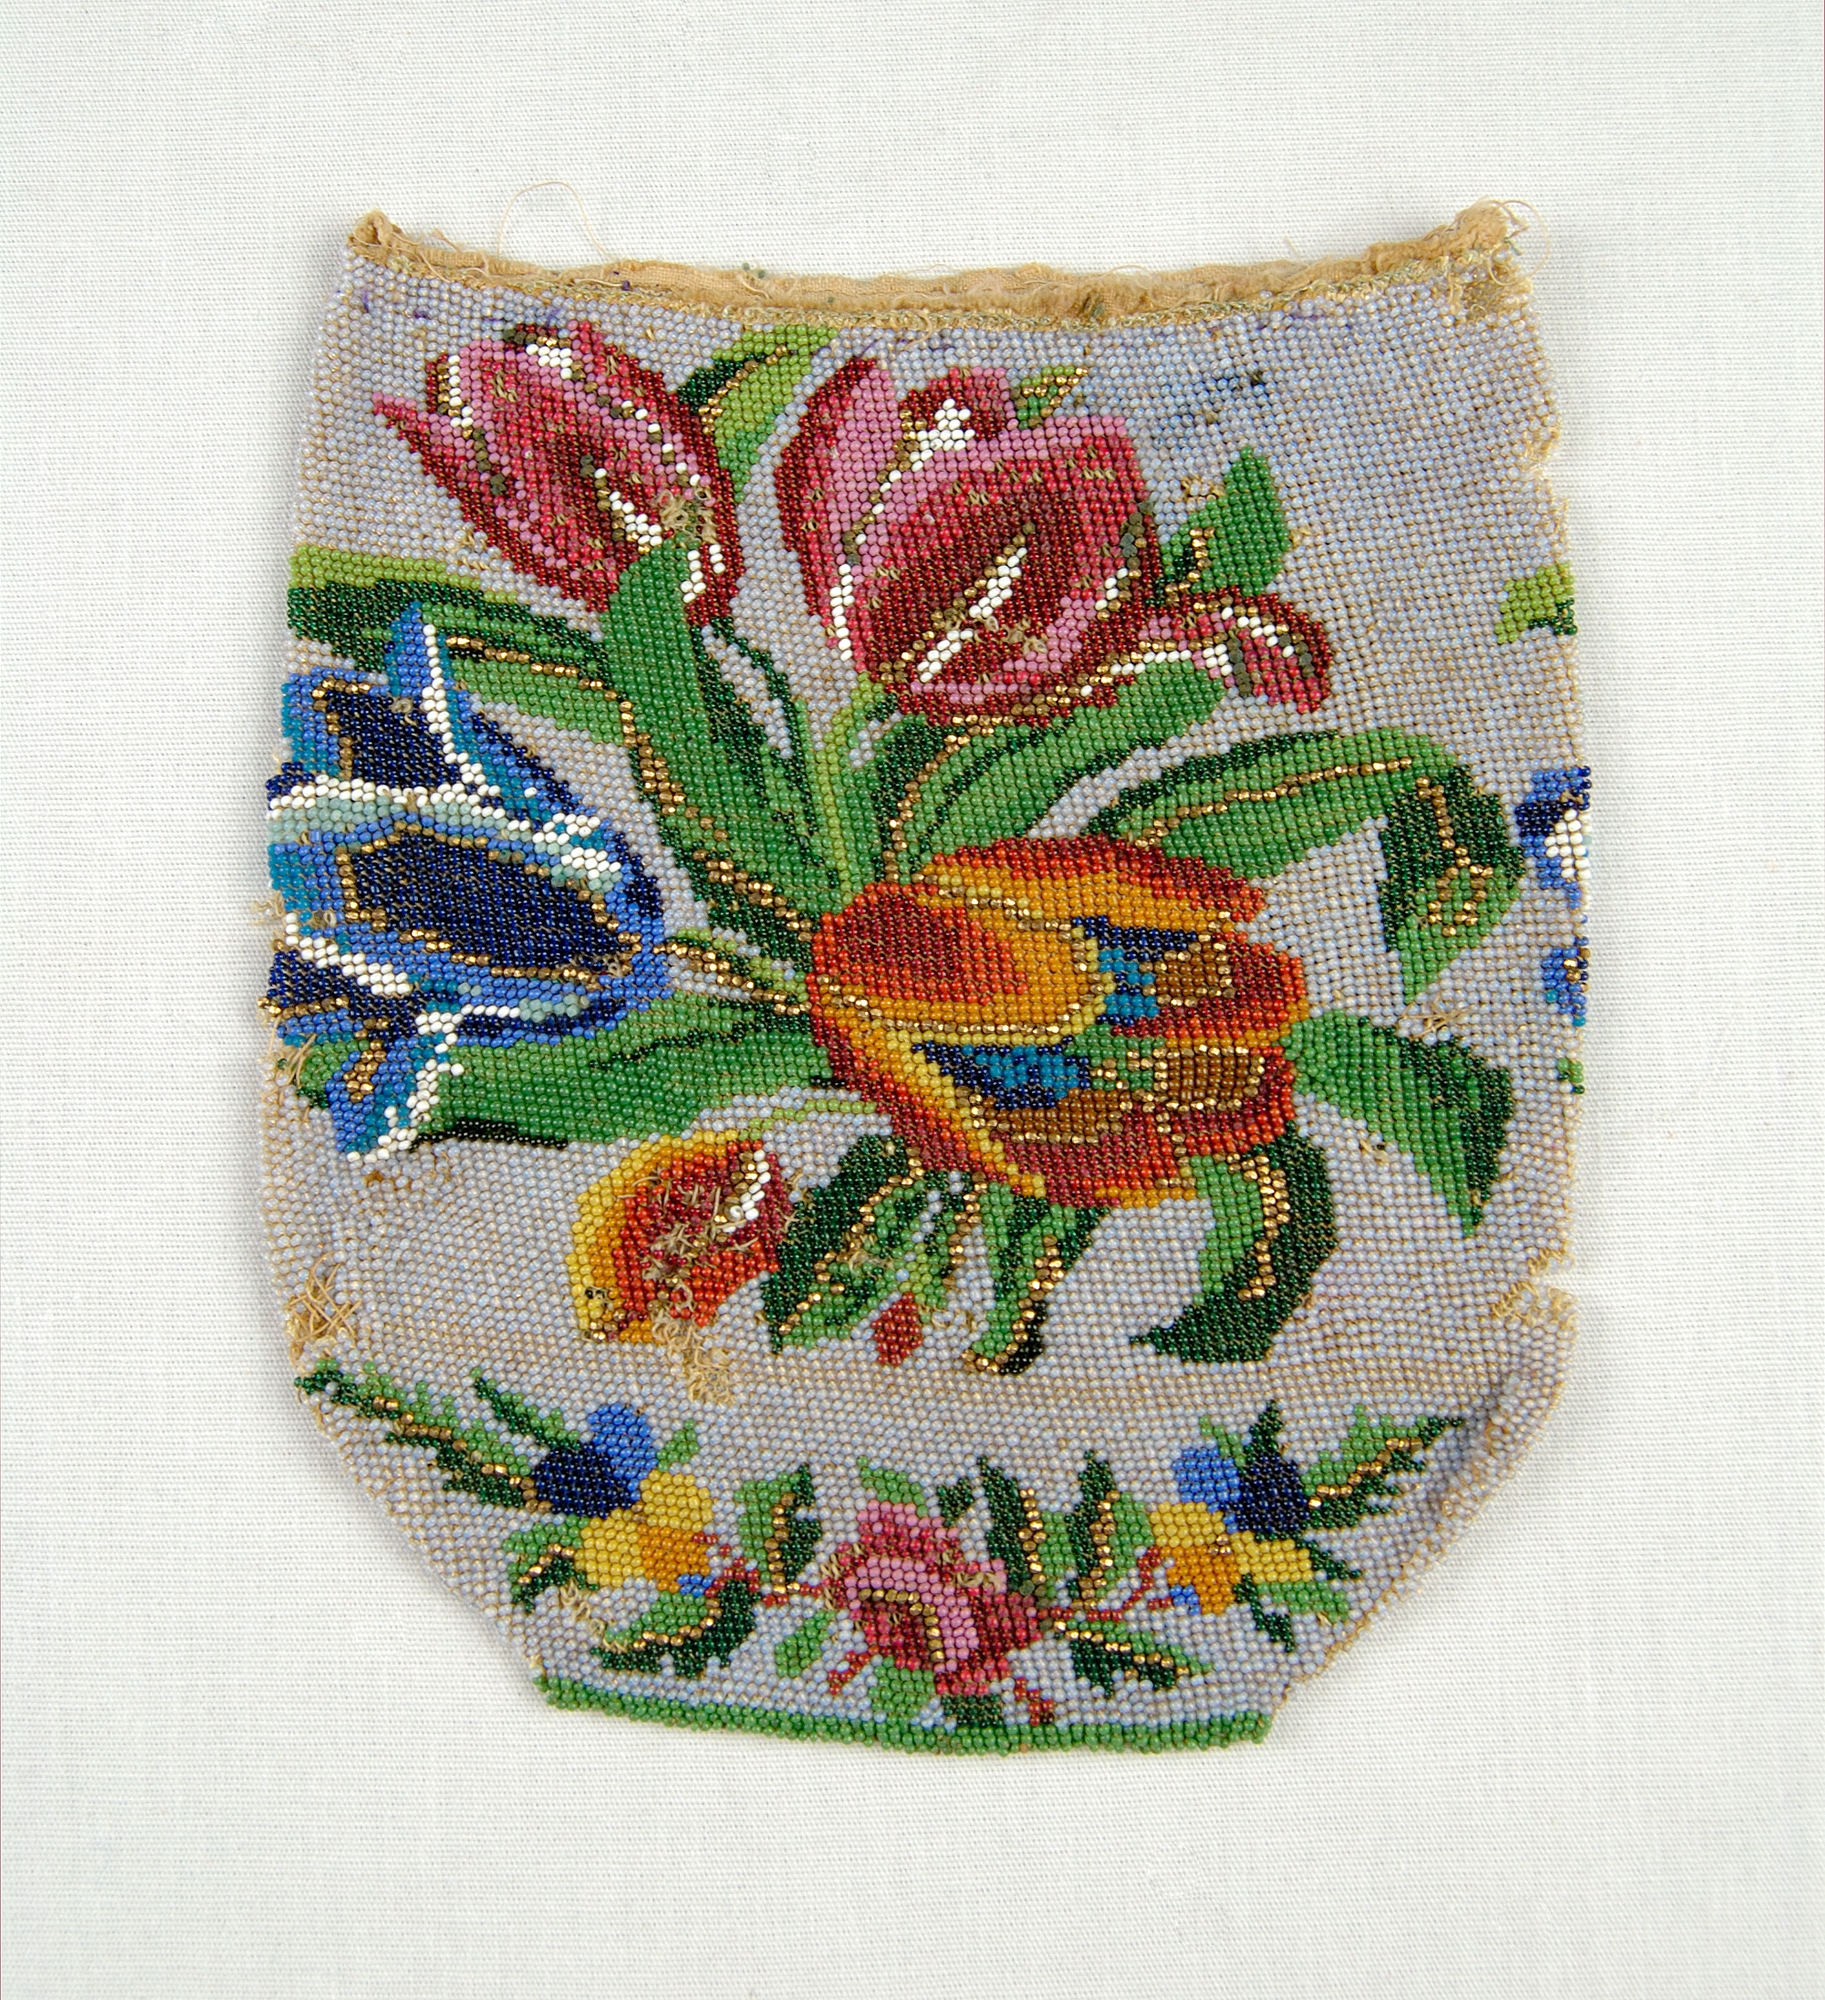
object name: pouch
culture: american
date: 1876-1900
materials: glass, linen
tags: flowers